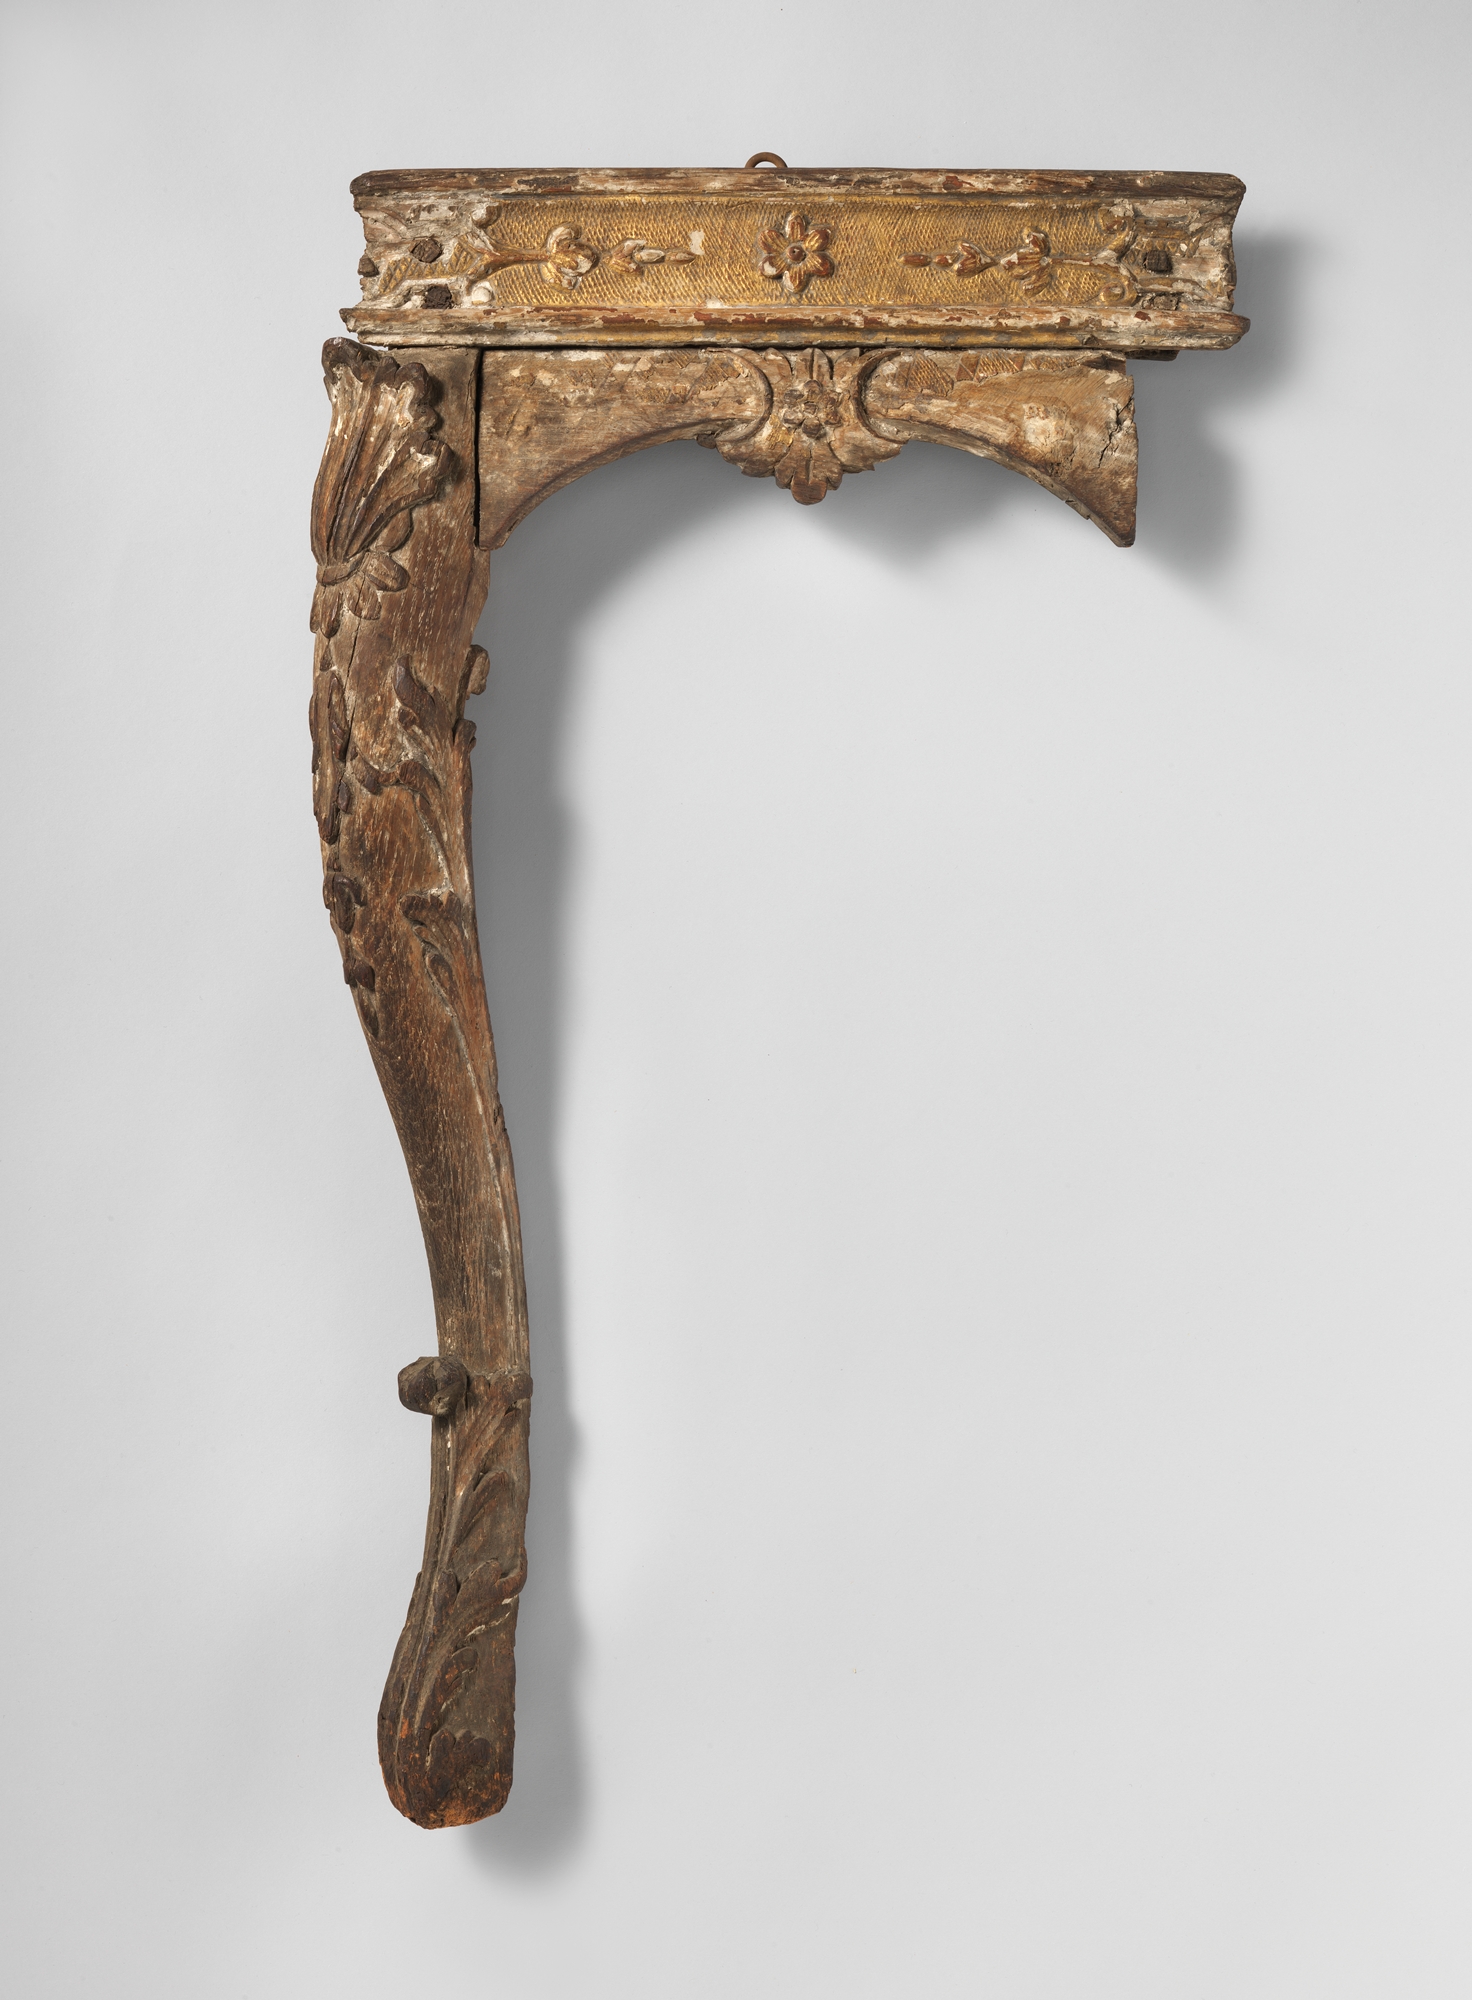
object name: table leg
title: Small table leg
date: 1667-1733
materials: gesso, wood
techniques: carving, gilding